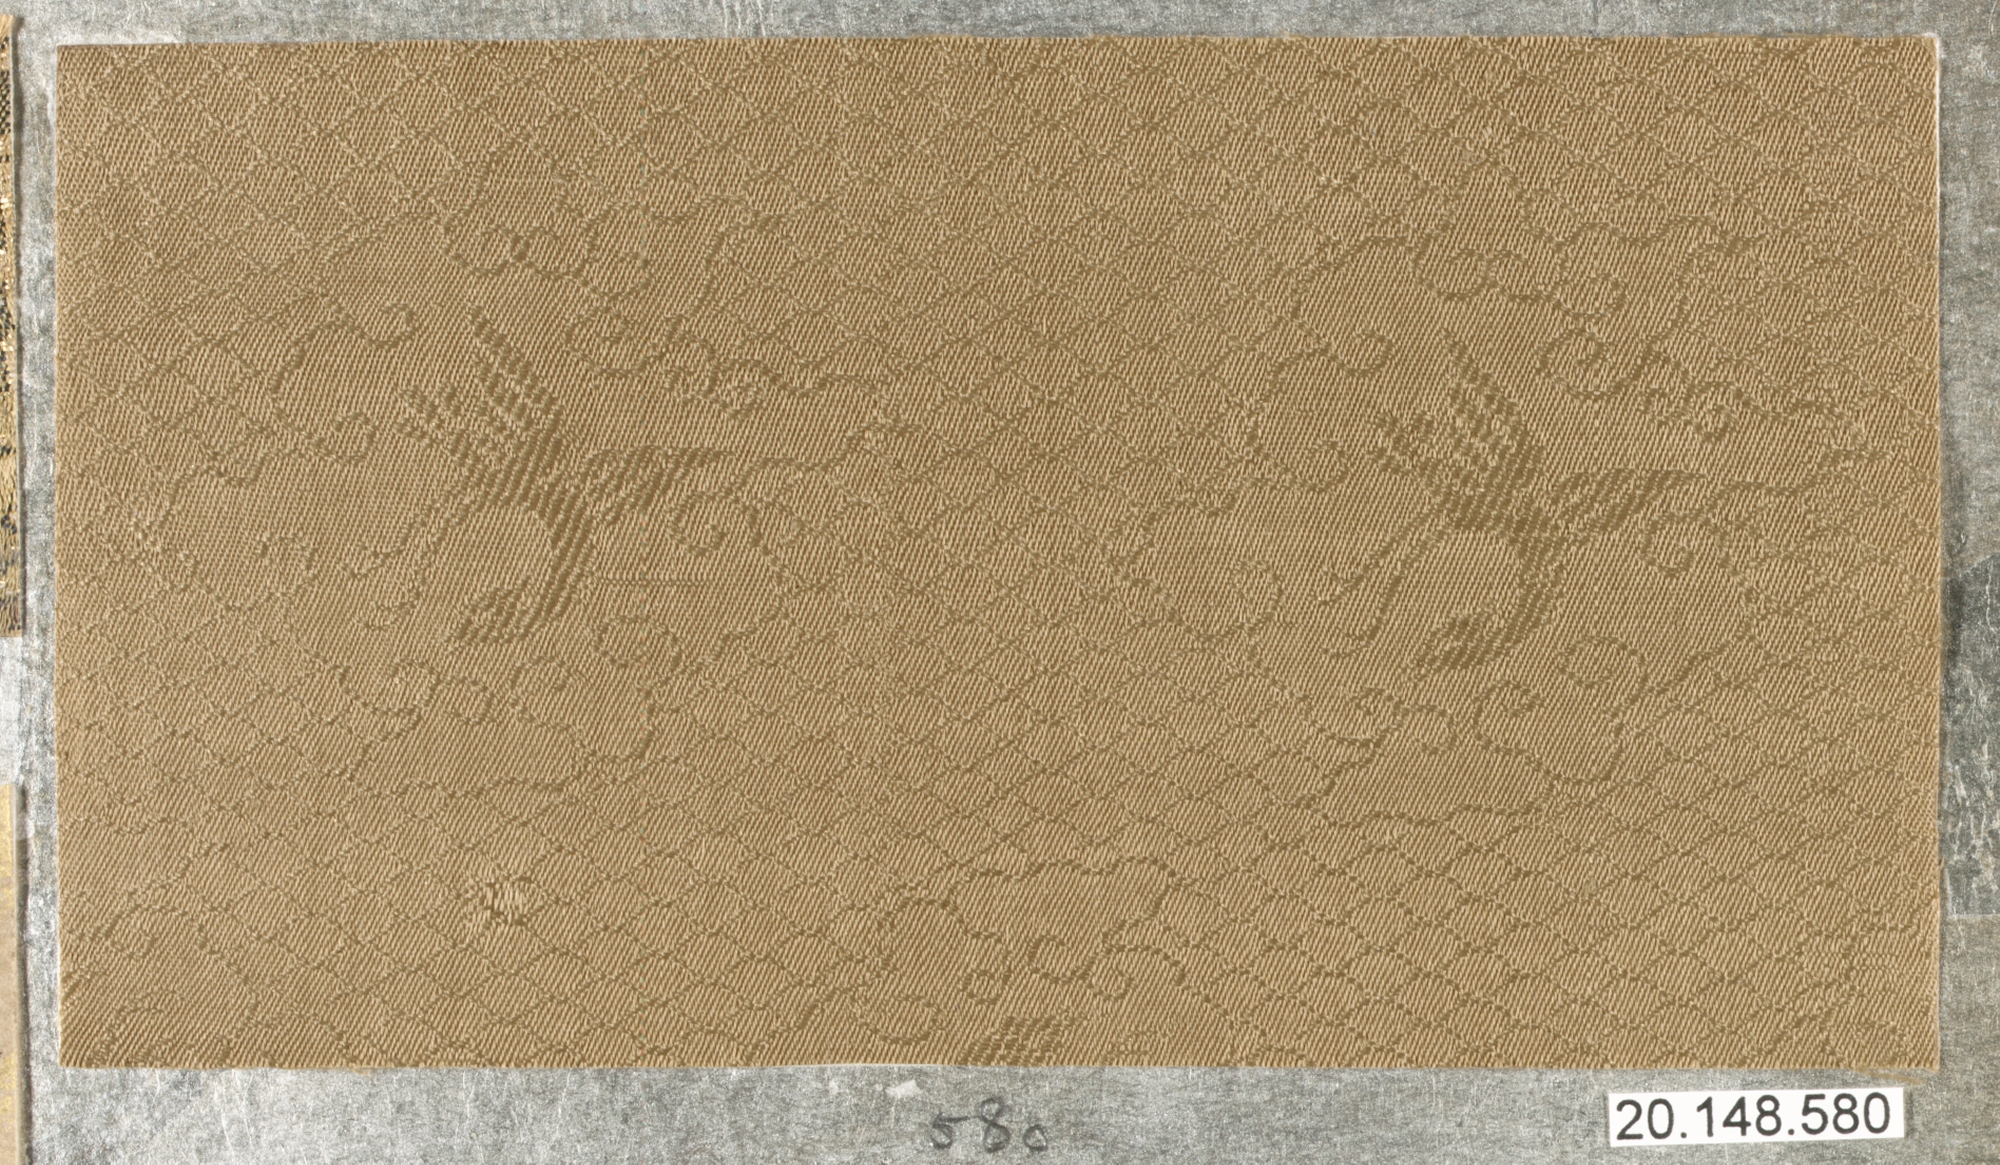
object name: piece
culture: japanese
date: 1701-1800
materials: silk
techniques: compound weave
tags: birds